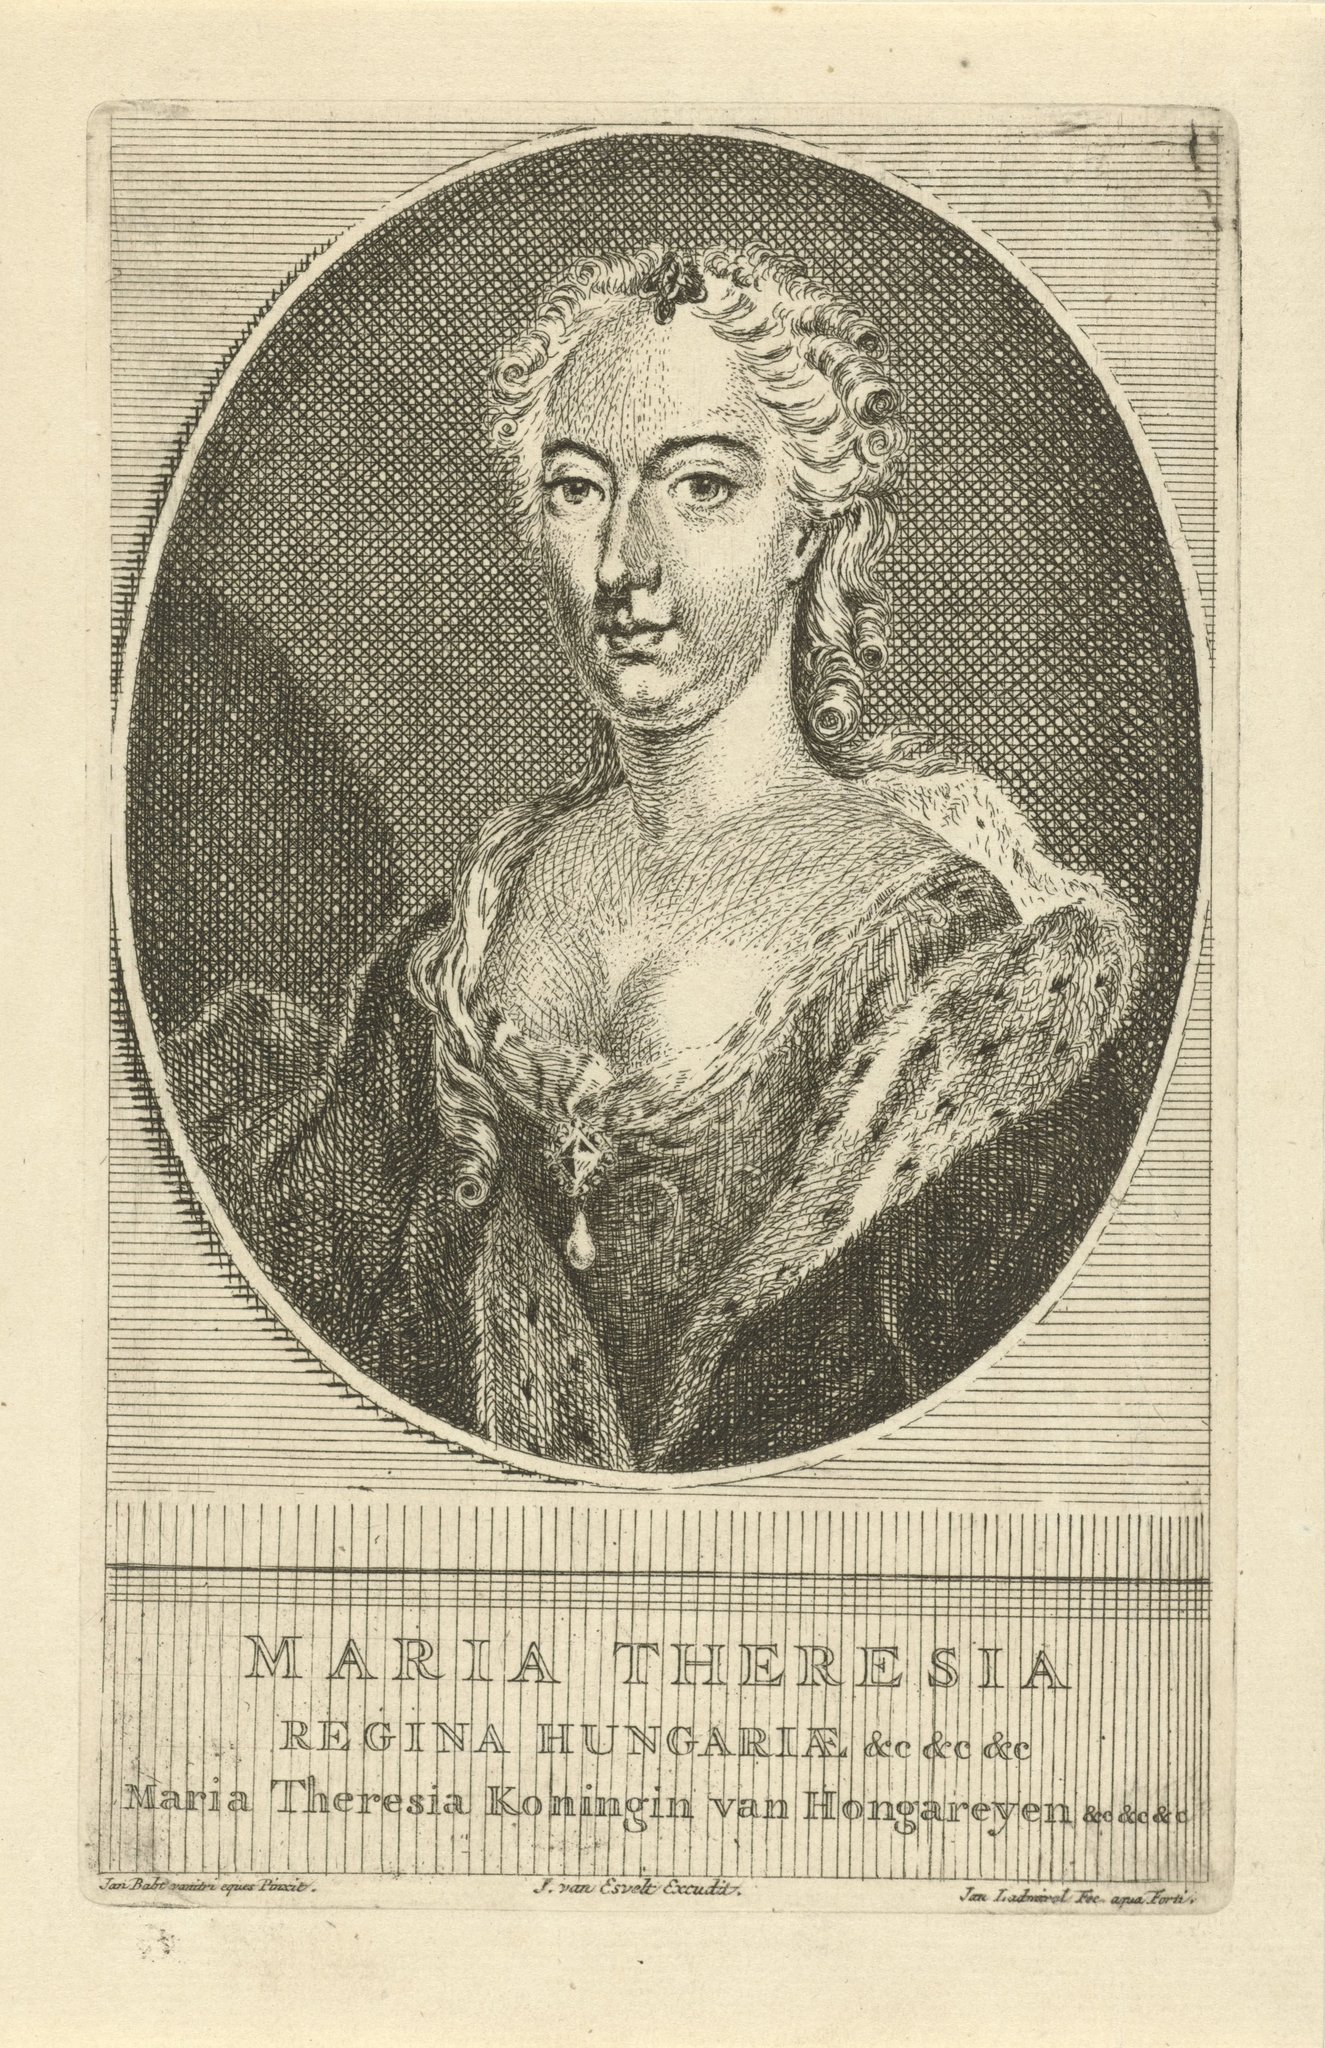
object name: print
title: Portret van keizerin Maria Theresia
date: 1736-1776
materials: paper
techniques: etching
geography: amsterdam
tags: maria theresia (rooms-duits keizerin)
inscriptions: collector's mark: Lugt 2228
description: Portret van Maria Theresia, keizerin van Oostenrijk, koningin van Hongarije en Bohemen.